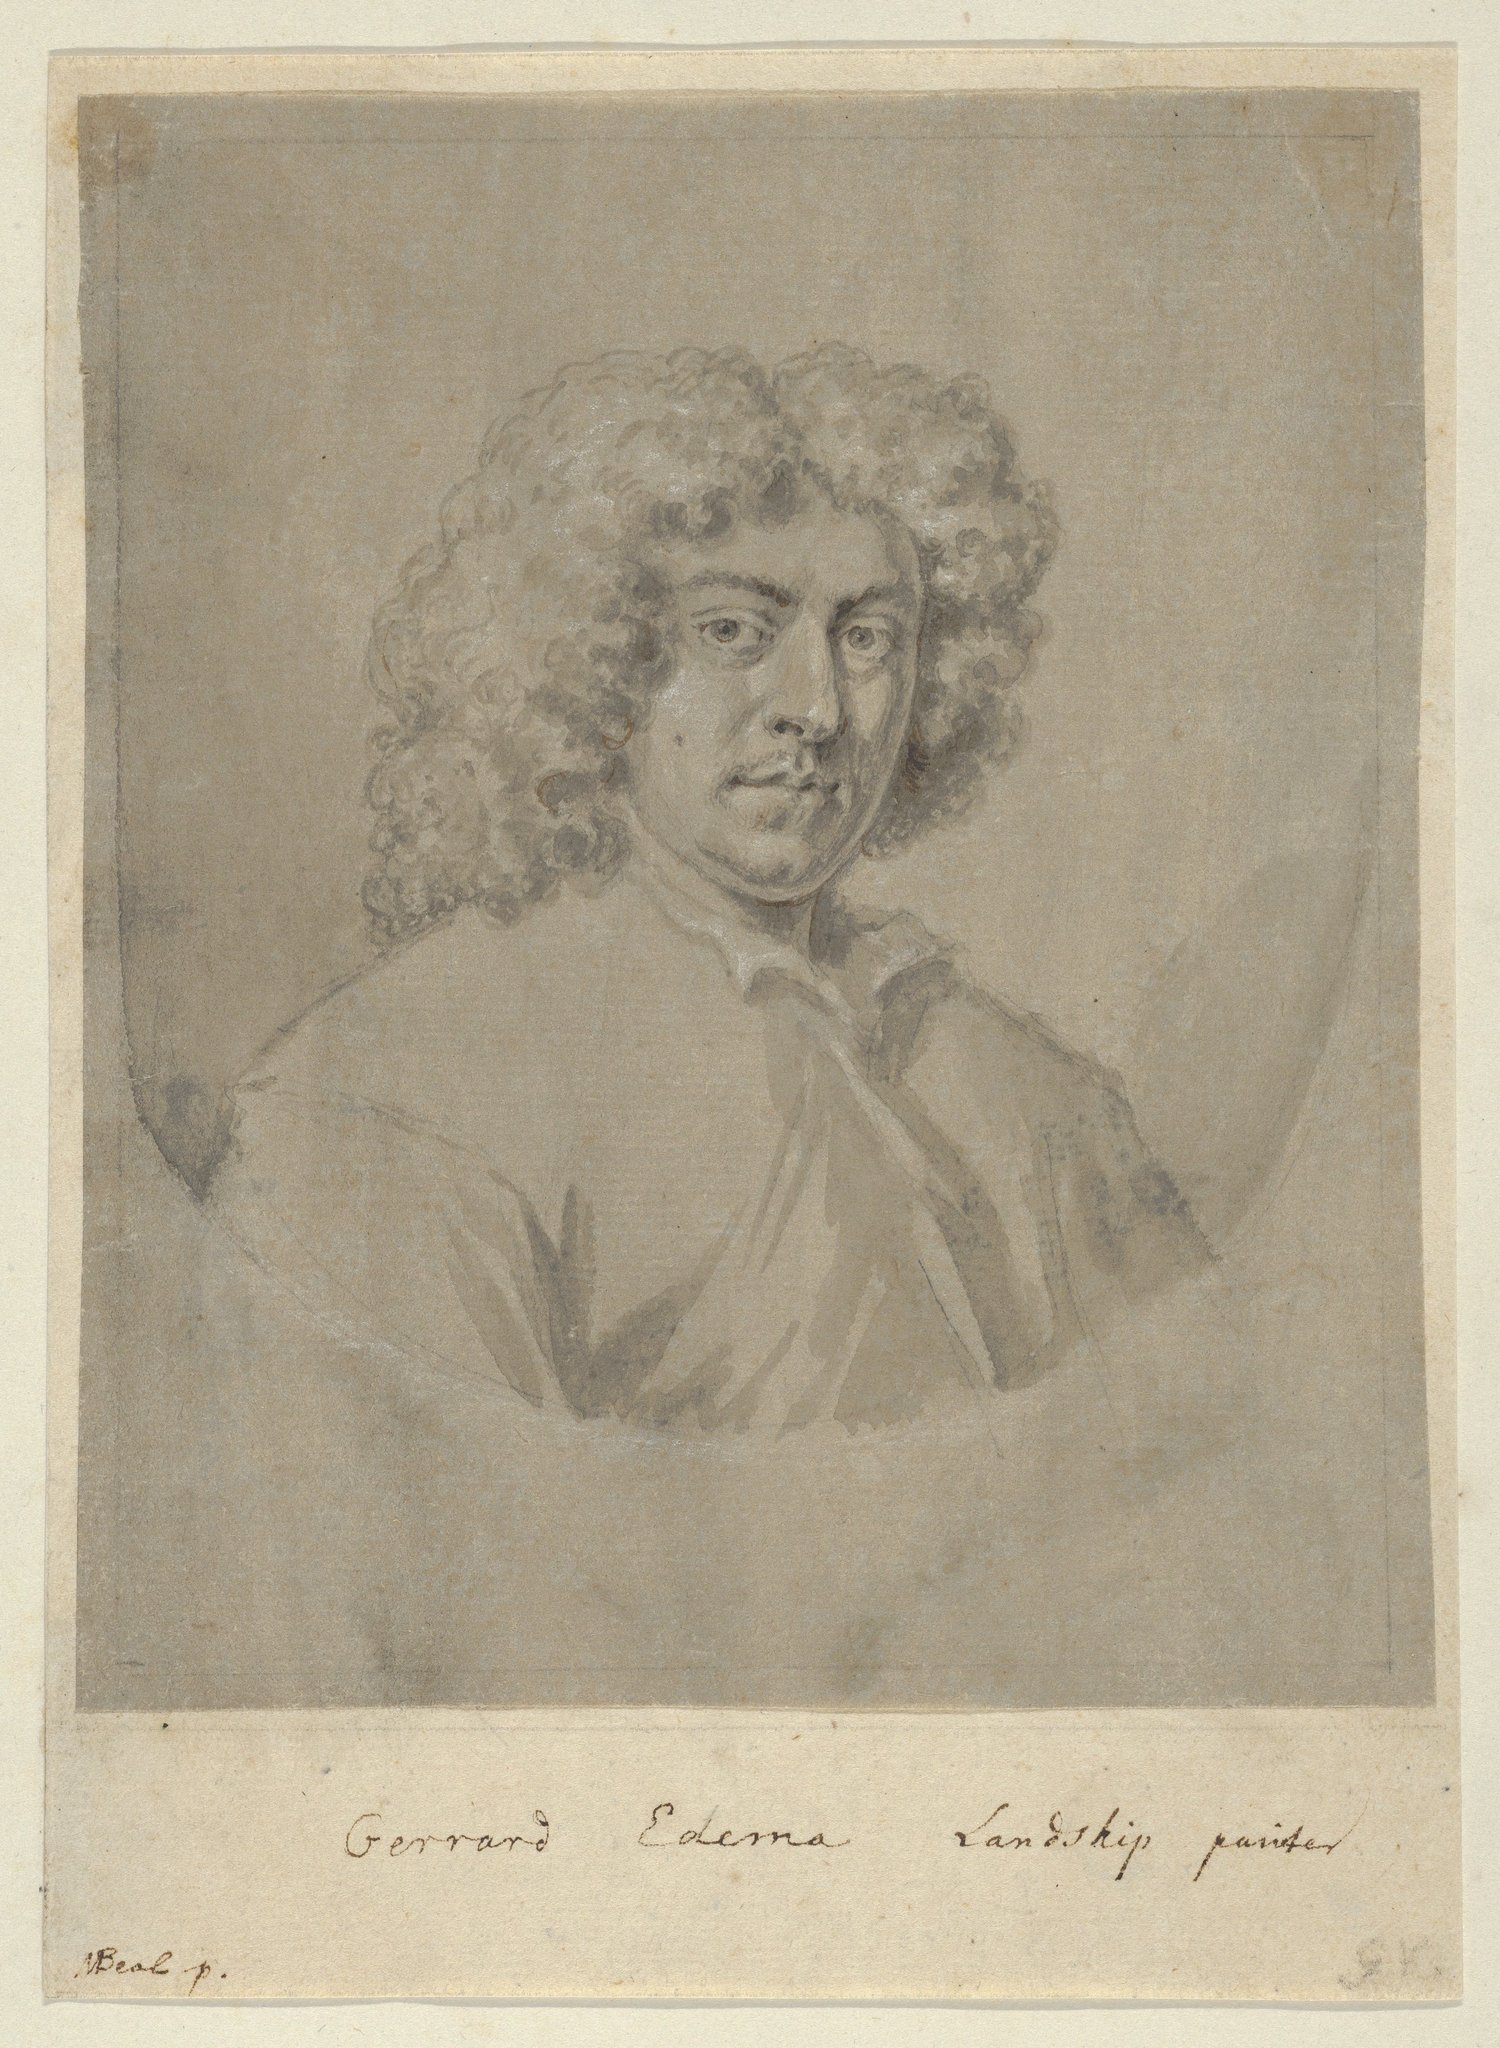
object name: drawing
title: Portrait of Gerard Edema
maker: mary beale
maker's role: artist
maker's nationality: british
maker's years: 1633-1699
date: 1680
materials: gouache, graphite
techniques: wash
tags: men,portraits